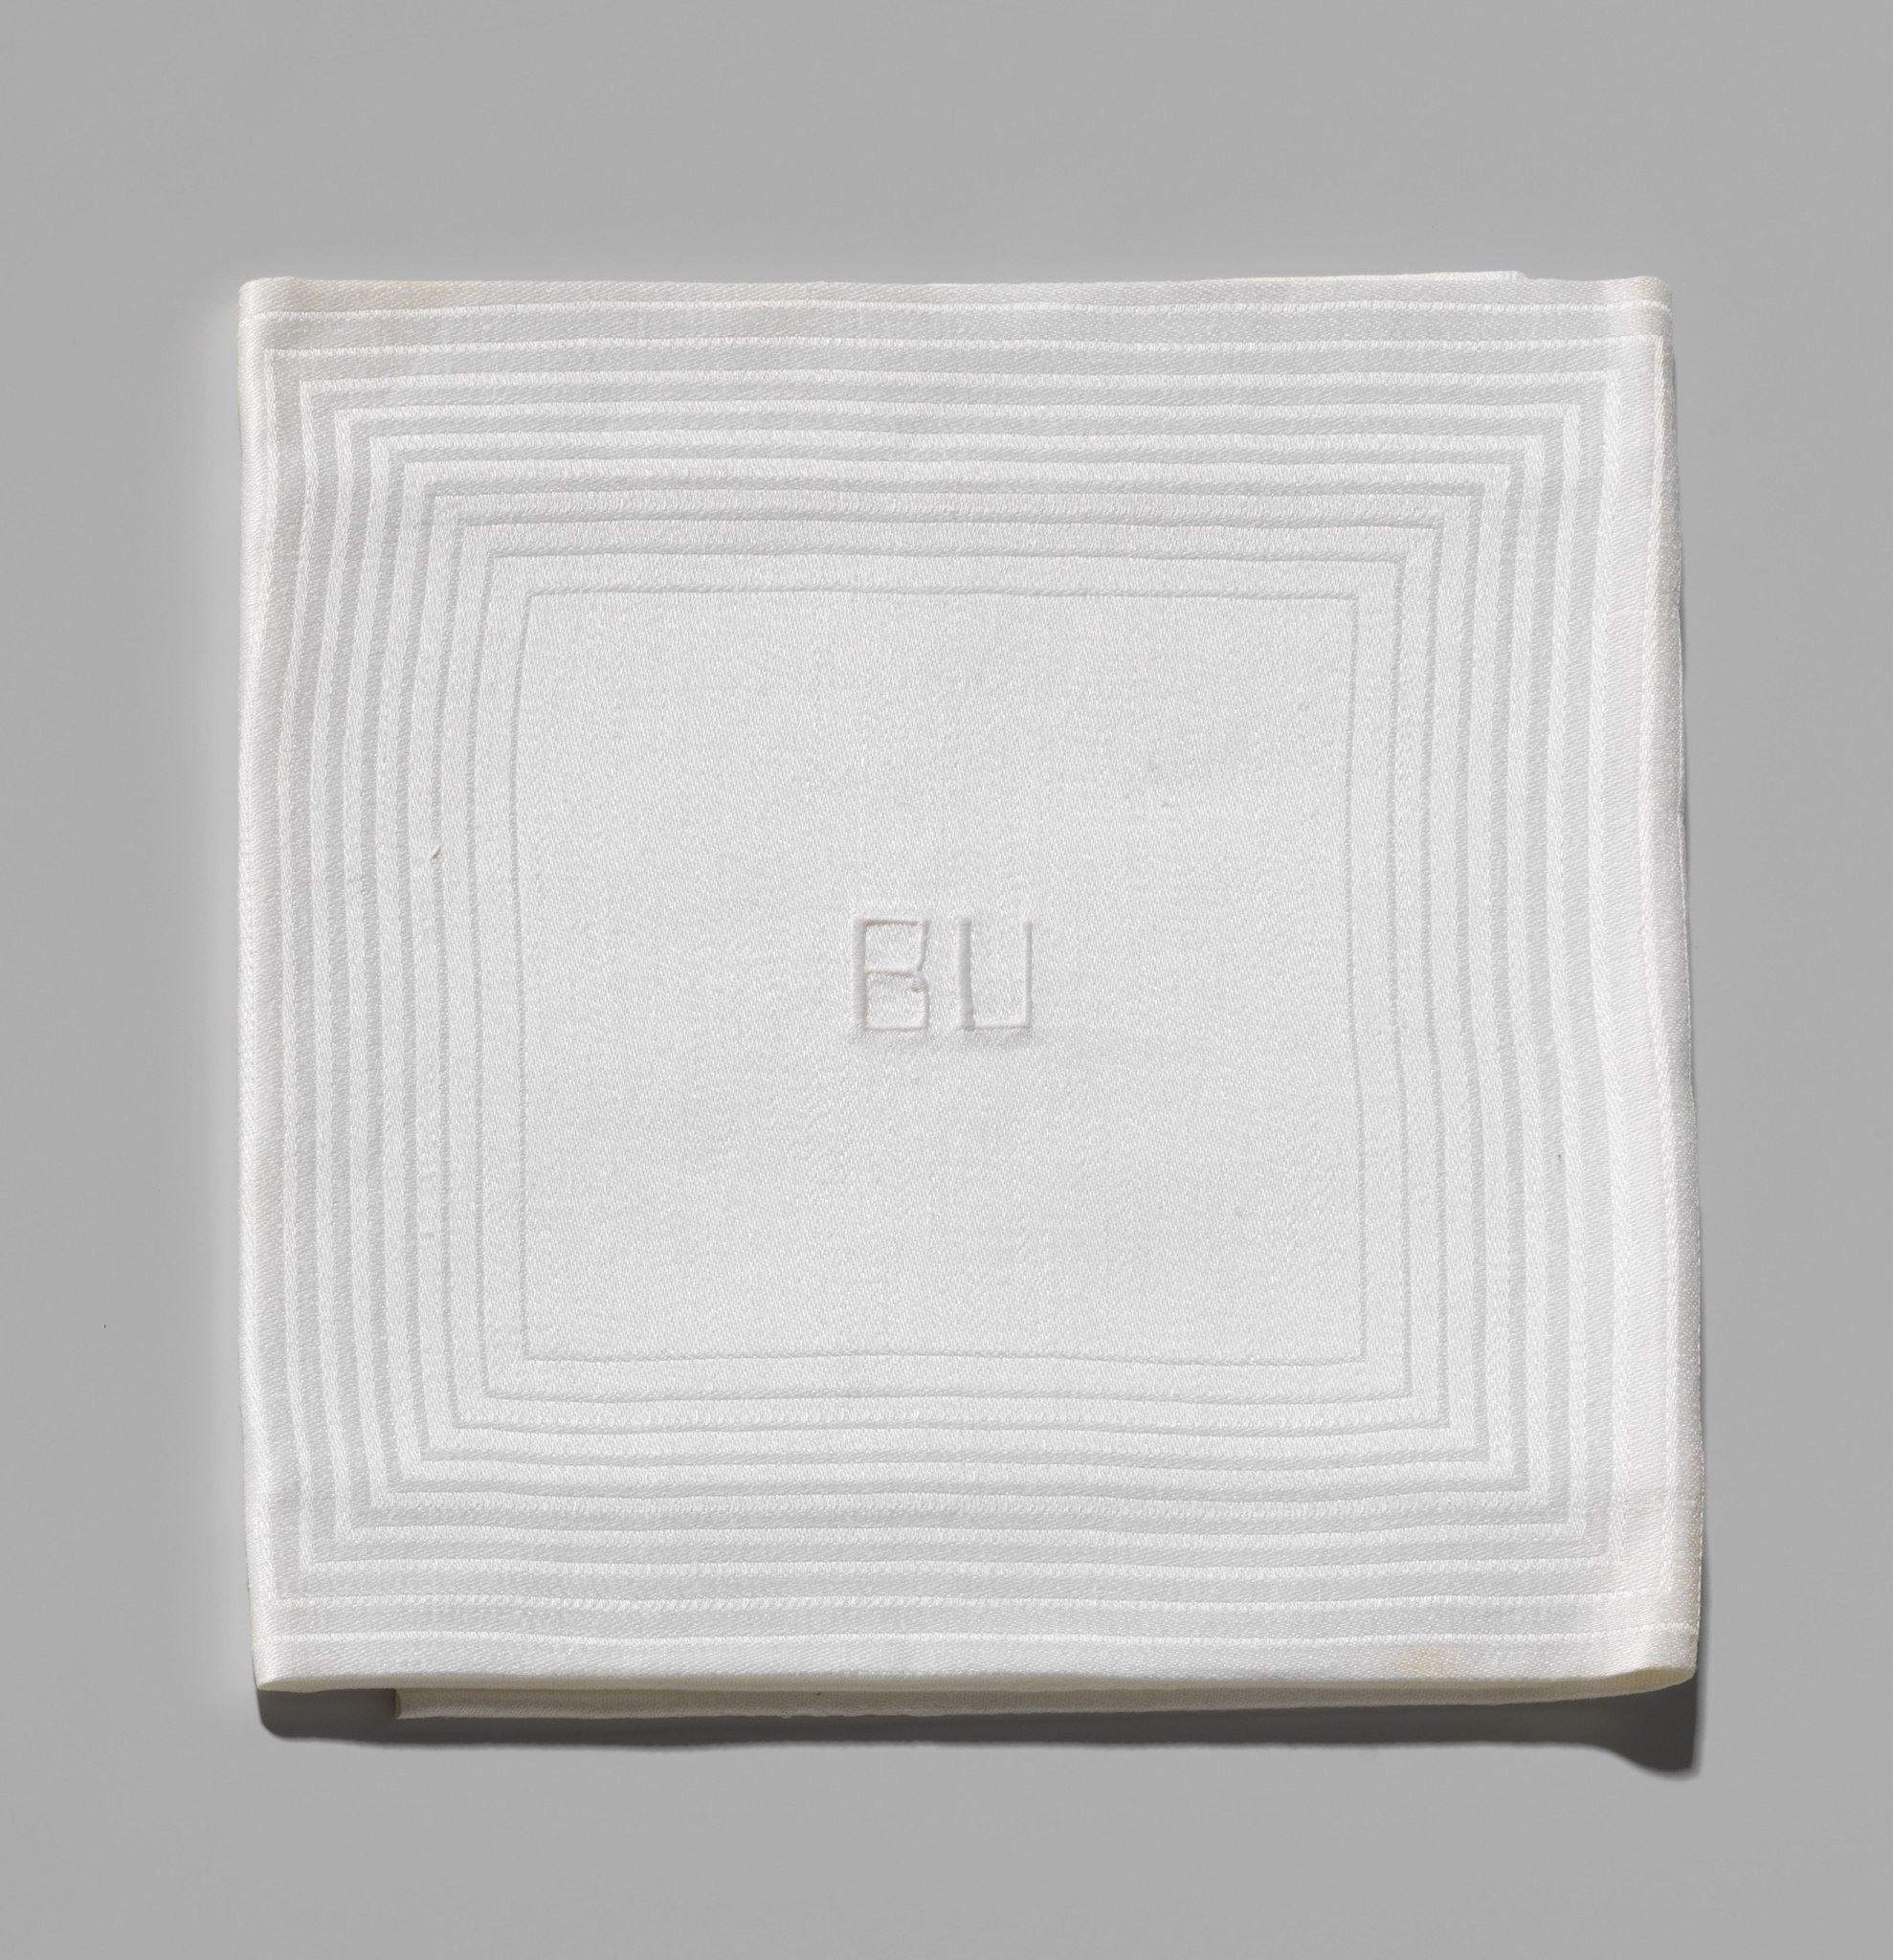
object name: napkin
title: Servet met geometrisch patroon en de initialen BU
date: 1935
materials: linen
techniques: damask, embroidered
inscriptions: initials: ‘BU’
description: Servet van wit linnendamast met ingeweven geometrisch patroon en de geborduurde initialen BU (Brusse-Urtebise).